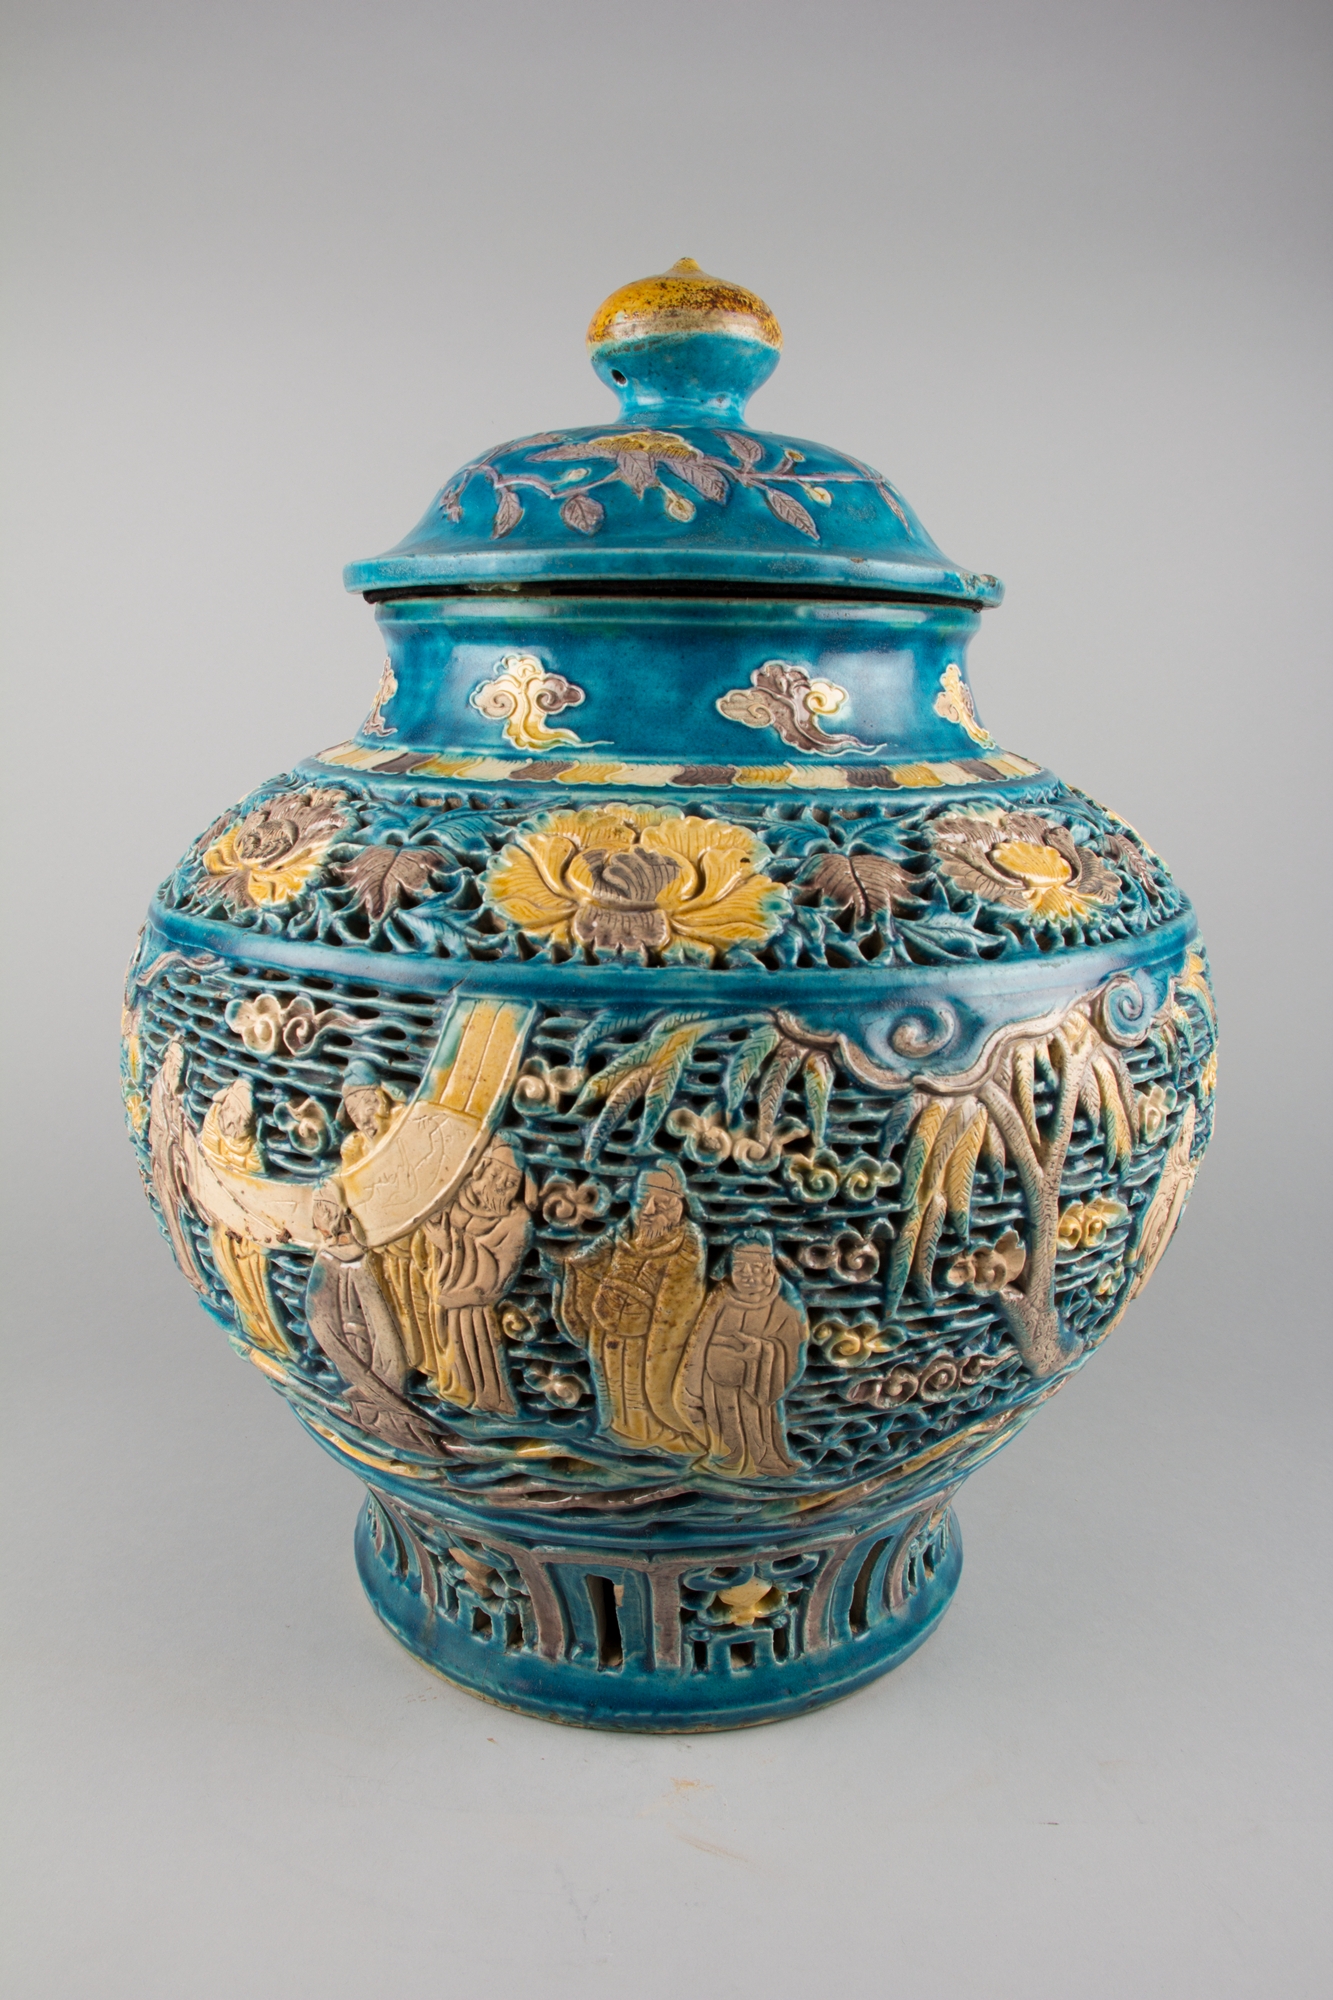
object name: covered jar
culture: chinese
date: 1501-1550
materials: biscuit, glaze, porcelain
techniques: carving, relief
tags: men,flowers